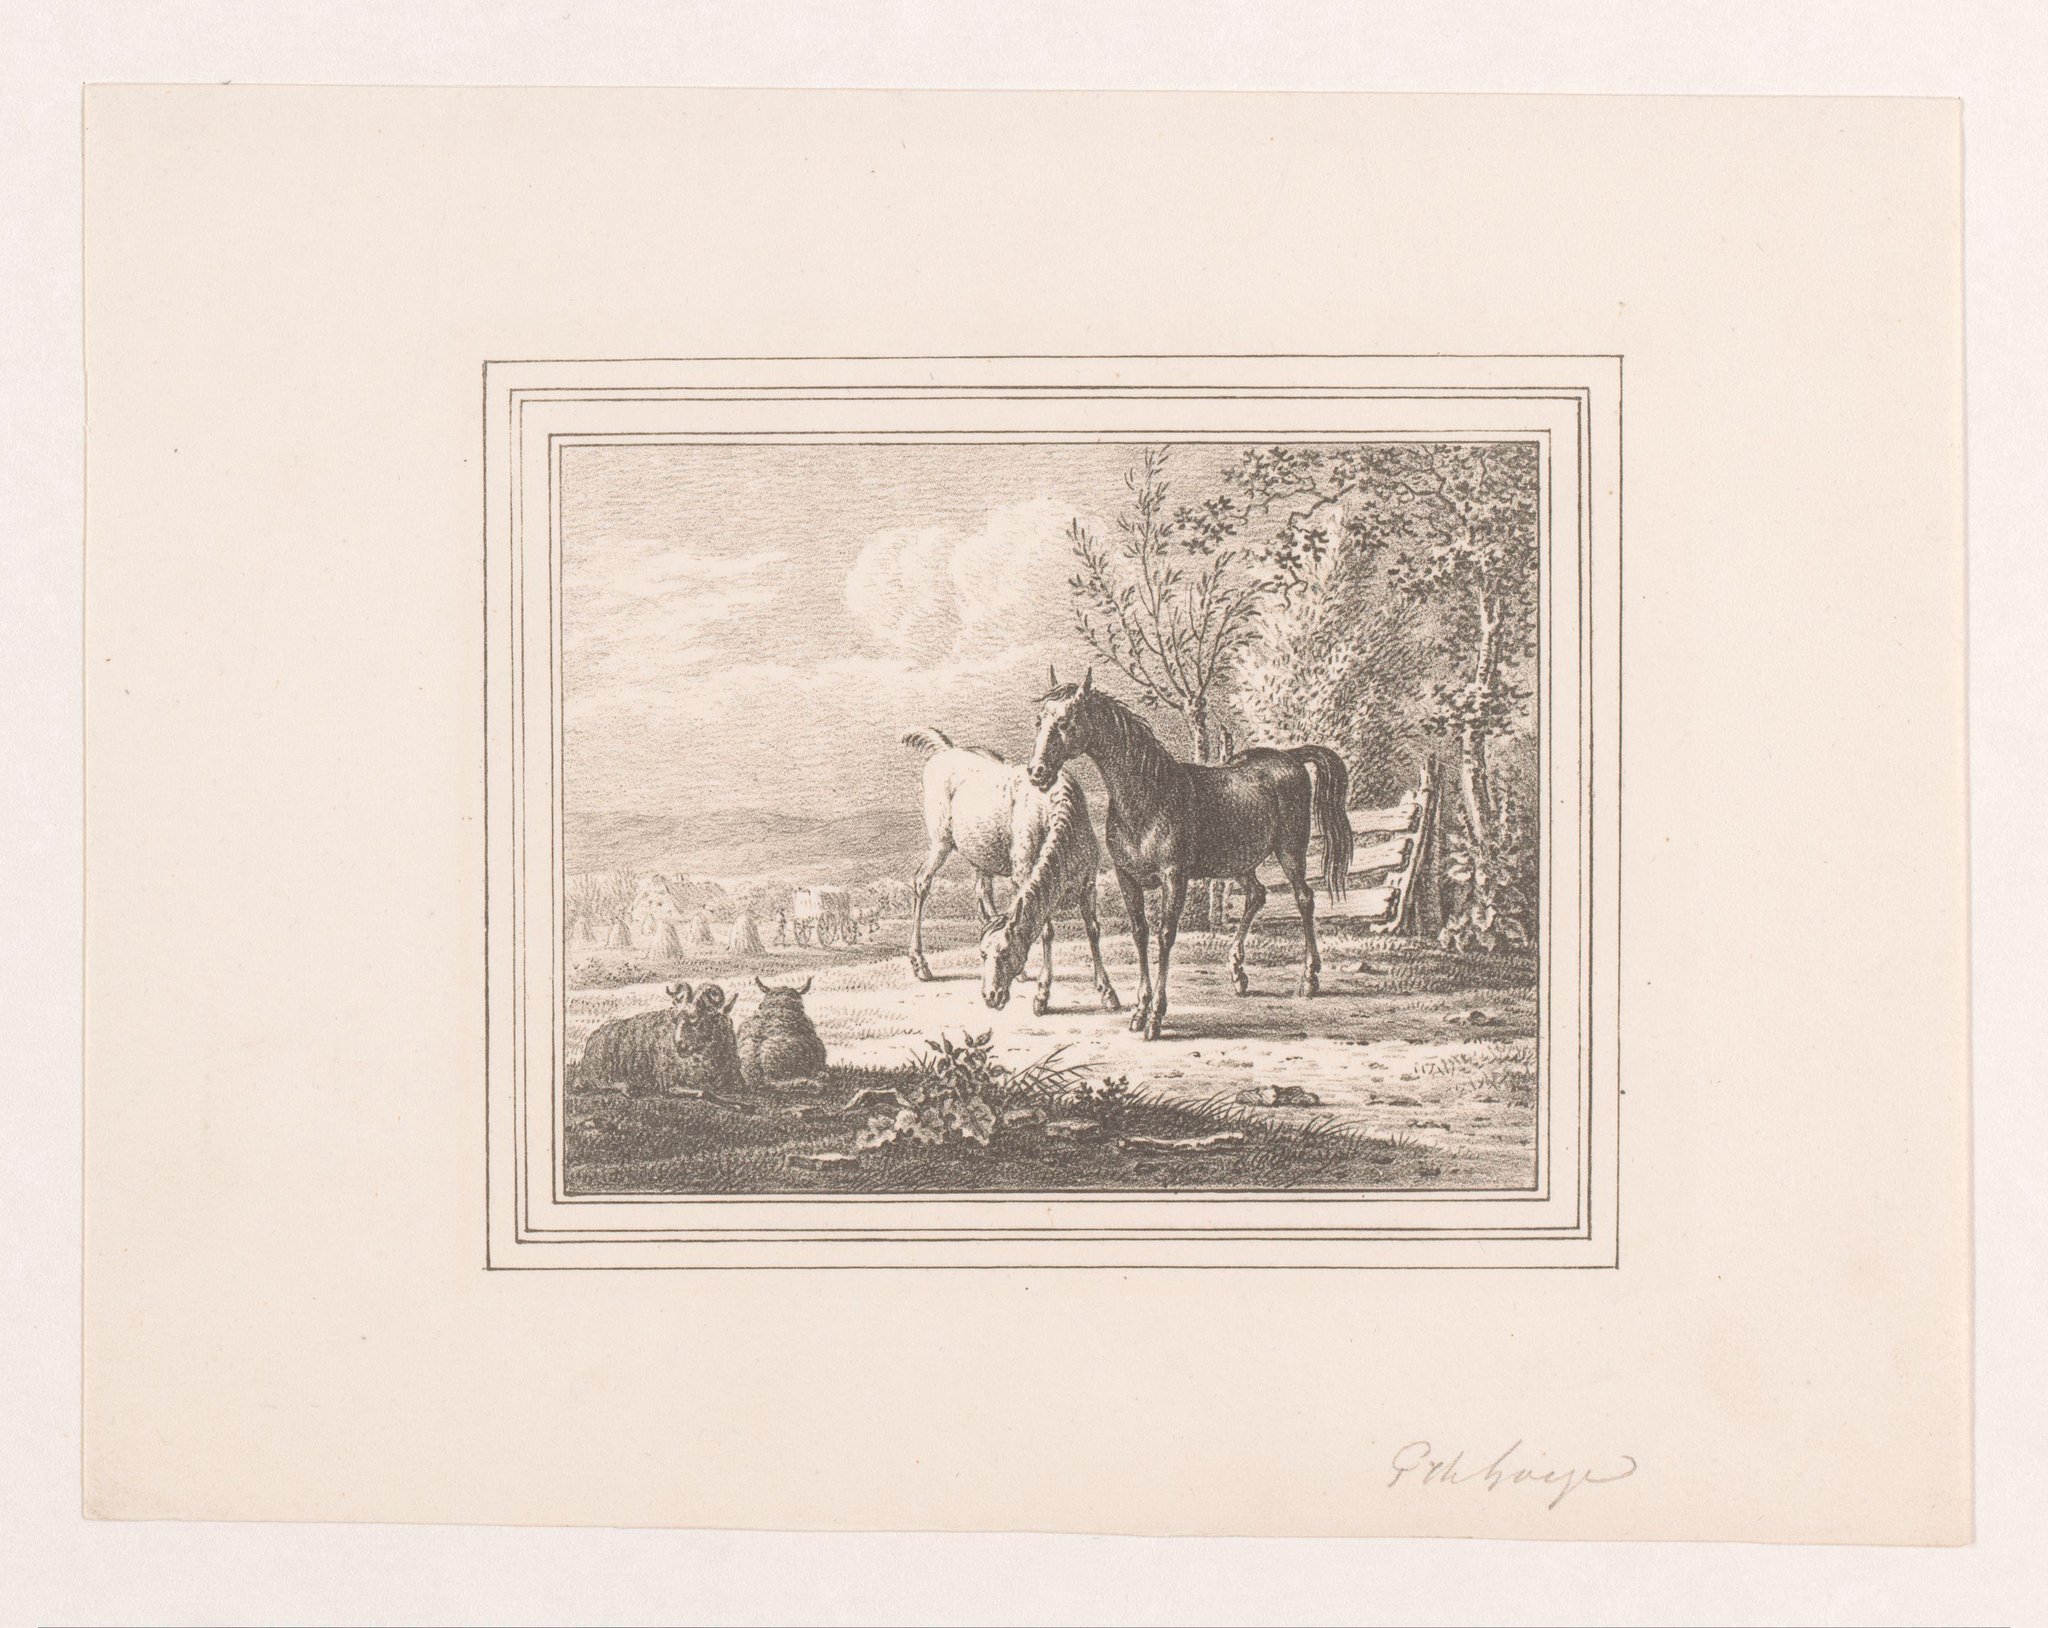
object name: print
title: Twee paarden en twee schapen in een weide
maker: pieter de goeje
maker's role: draughtsman, print maker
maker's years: 1789-1859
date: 1809-1859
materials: paper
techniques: lithograph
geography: netherlands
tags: agricultural products and by-products: hay (+ harvesting ~ agricultural processes), meadow, pasture, sheep, horse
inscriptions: collector's mark: Lugt 2228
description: De schapen liggen op de grond. In de achtergrond staan hooiruiters en een paard en wagen.